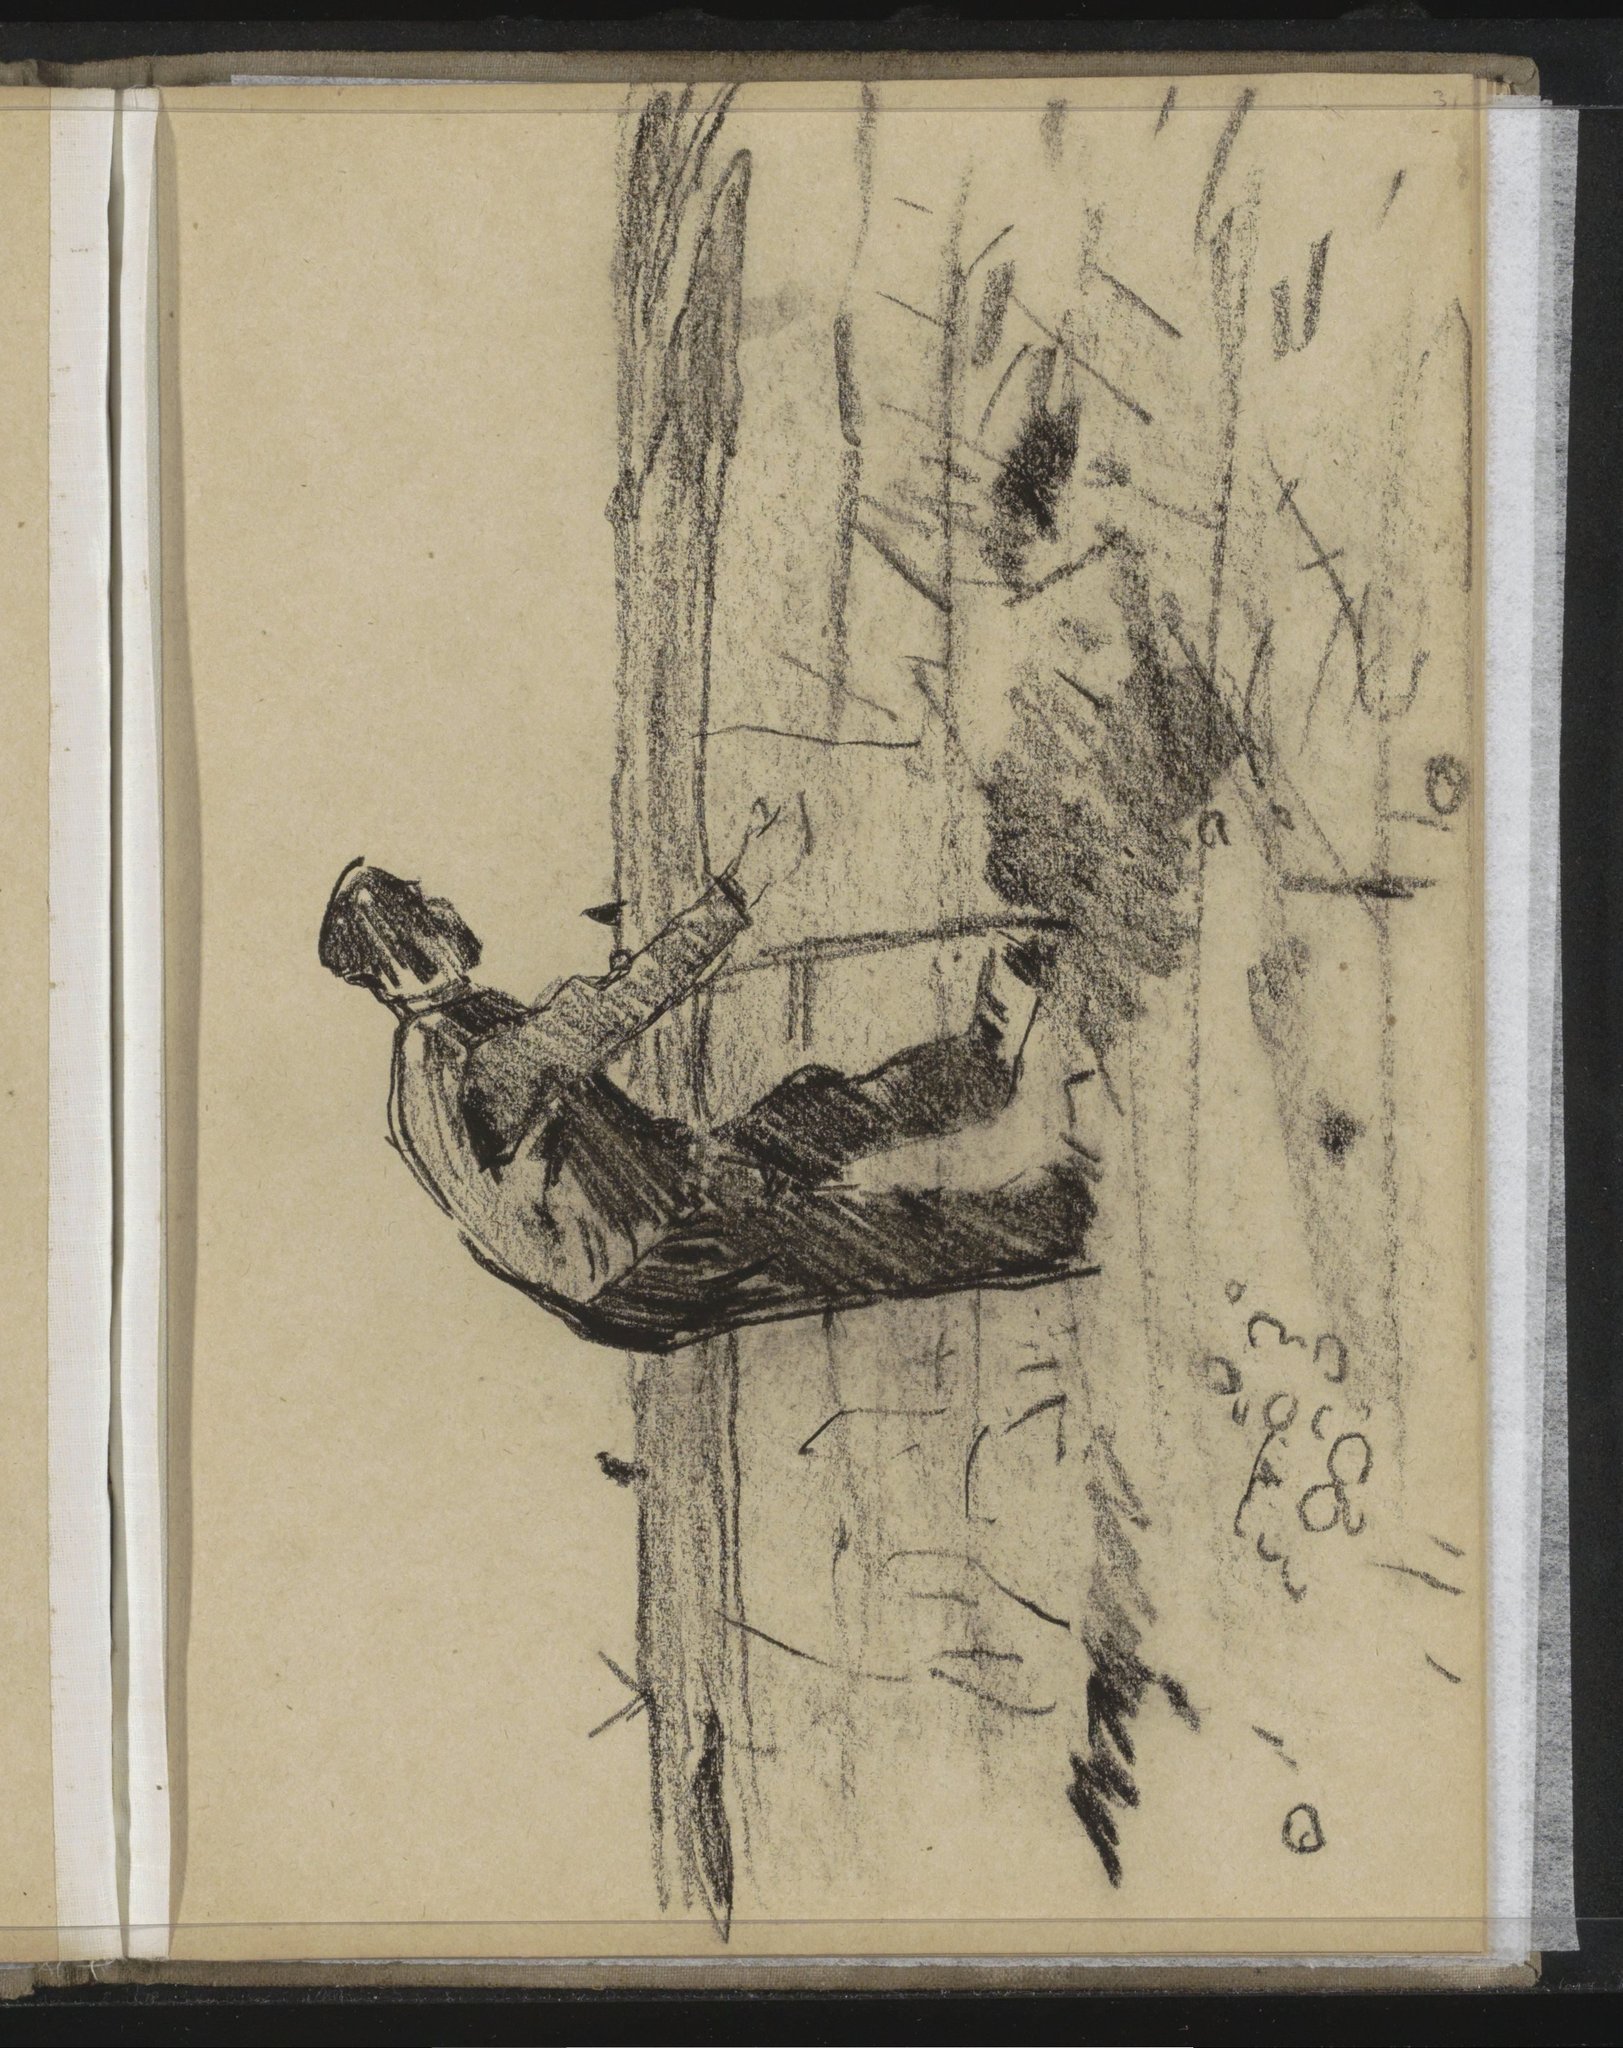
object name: sketchbook leaf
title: Boer op het land, mogelijk zaaiend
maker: willem witsen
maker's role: draughtsman, painter, print maker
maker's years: 1860-1923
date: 1893-1897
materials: chalk, paper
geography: ede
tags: farmers, cultivated land, sowing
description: Pagina 31 uit een schetsboek met 28 bladen.